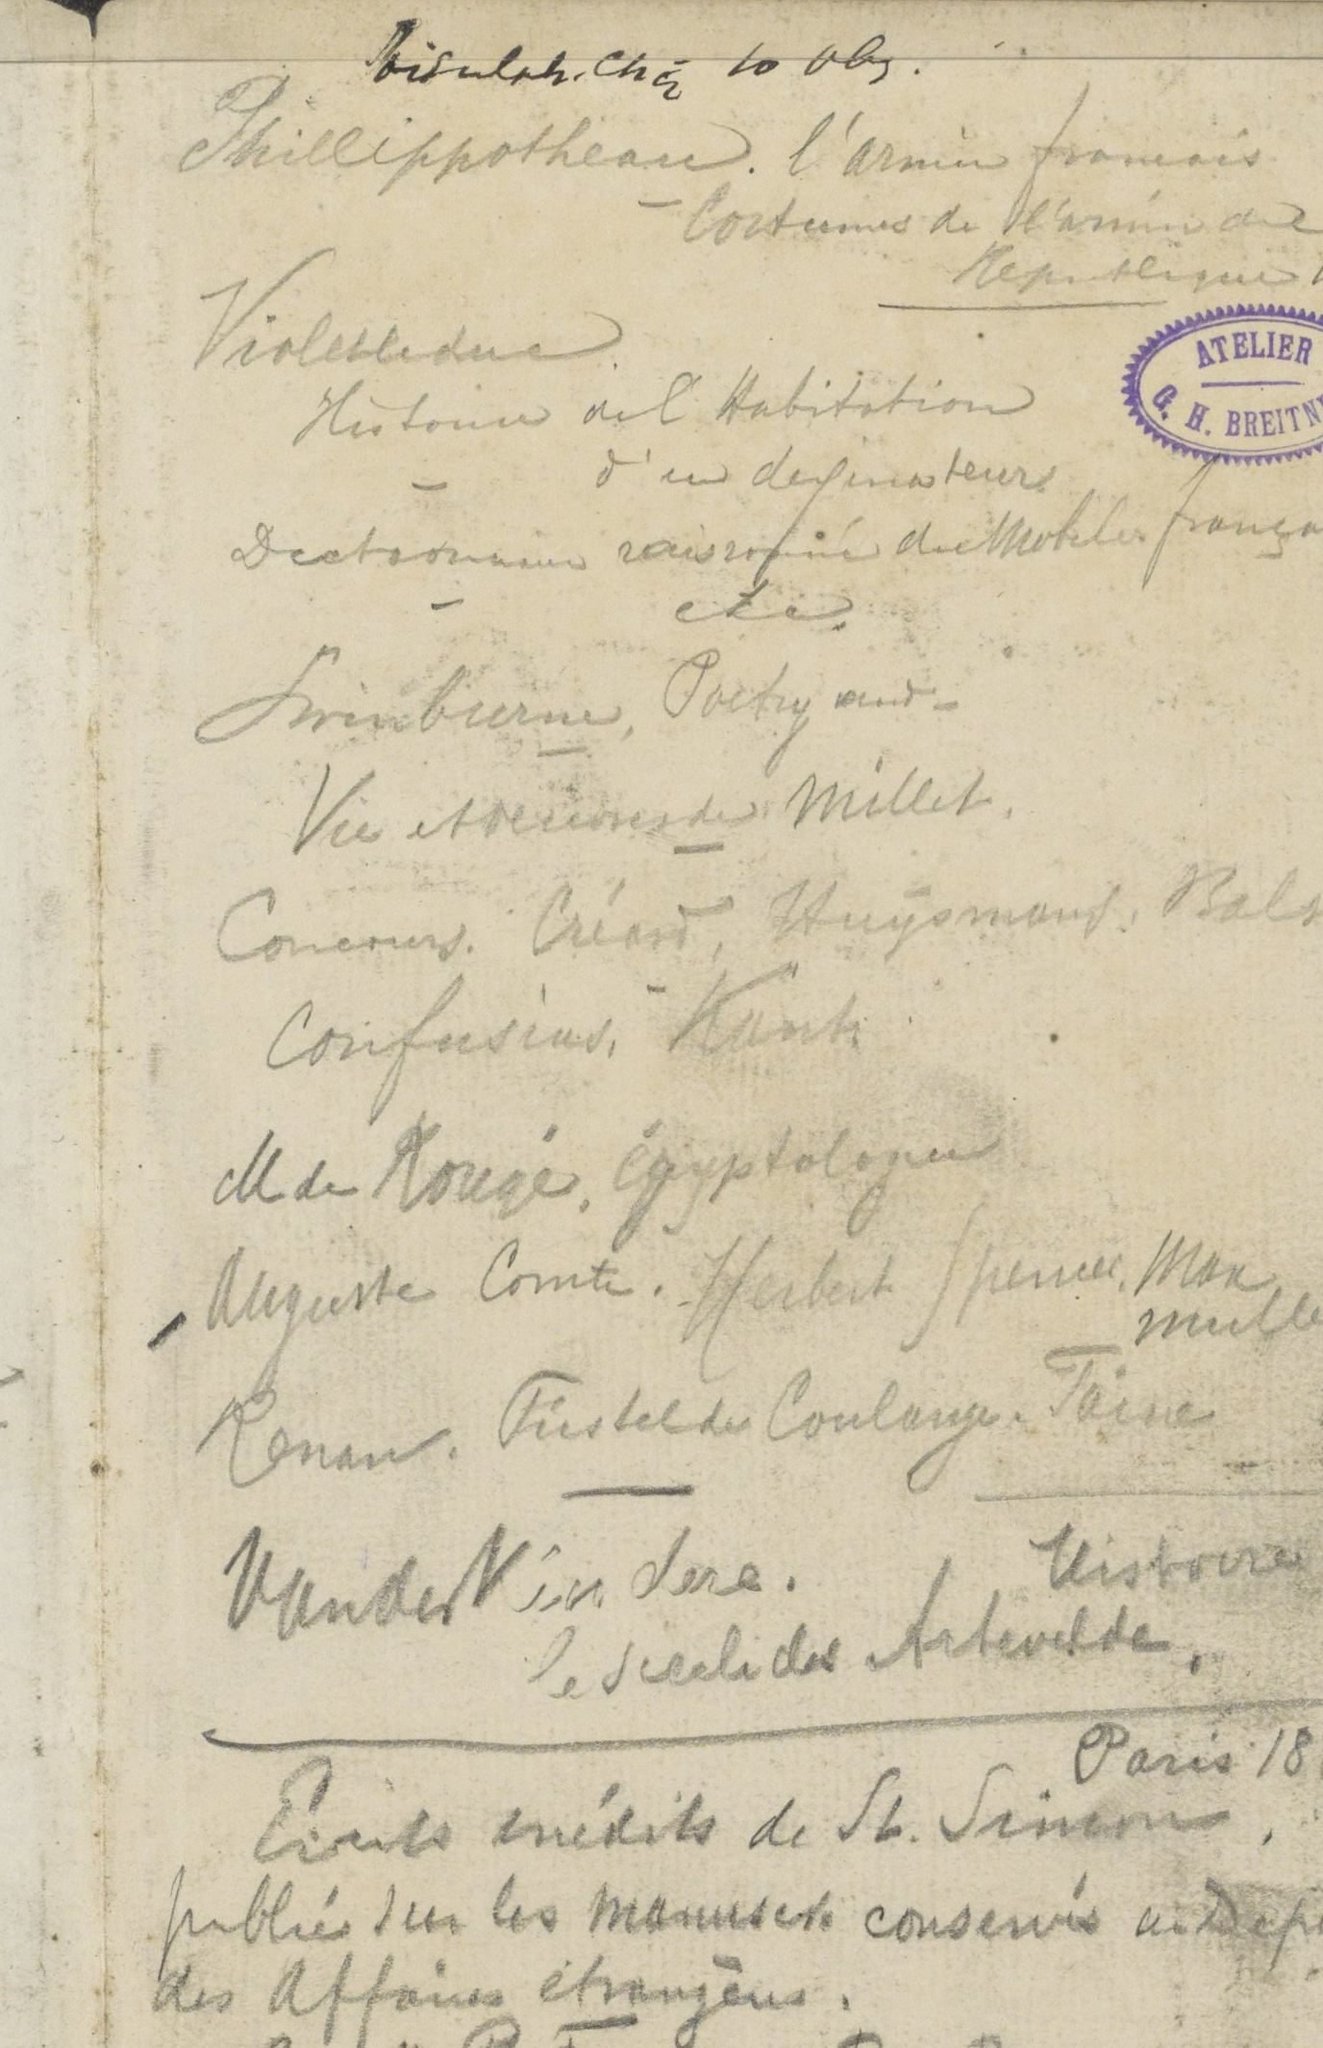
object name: sketchbook leaf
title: Boektitels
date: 1880-1882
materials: paper, pencil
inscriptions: annotation: ‘[...]’, workshop stamp: Lugt 291d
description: Blad 1 recto uit een schetsboek met 16 bladen.